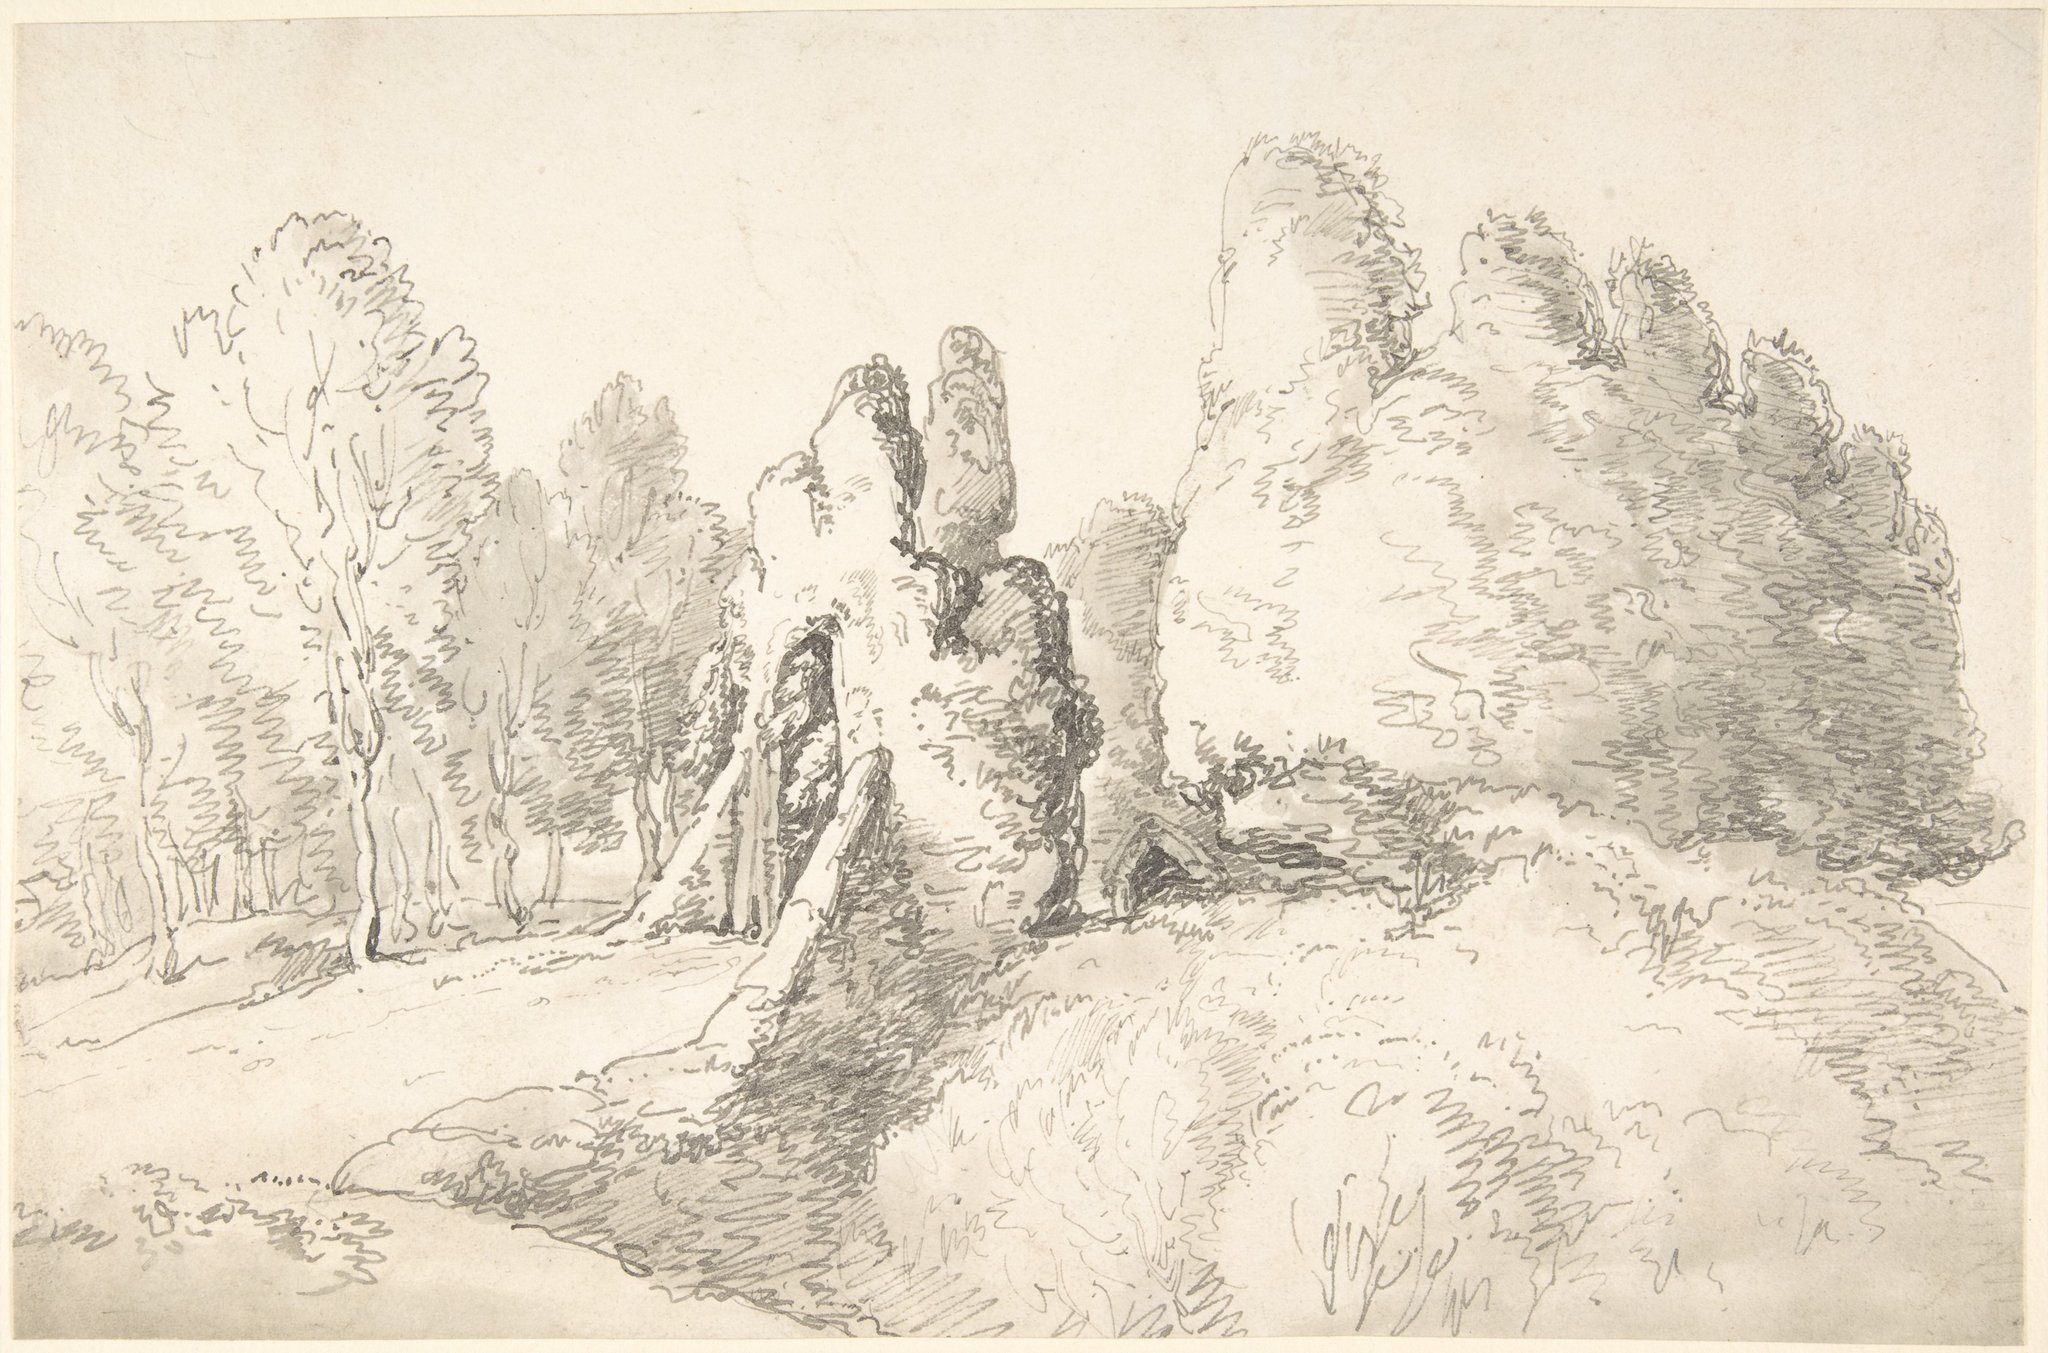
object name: drawing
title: Wooded Landscape with Ruins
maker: thomas rowlandson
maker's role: artist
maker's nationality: british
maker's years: 1757-1827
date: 1780-1827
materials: ink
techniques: brush, pen, wash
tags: ruins,landscapes,trees